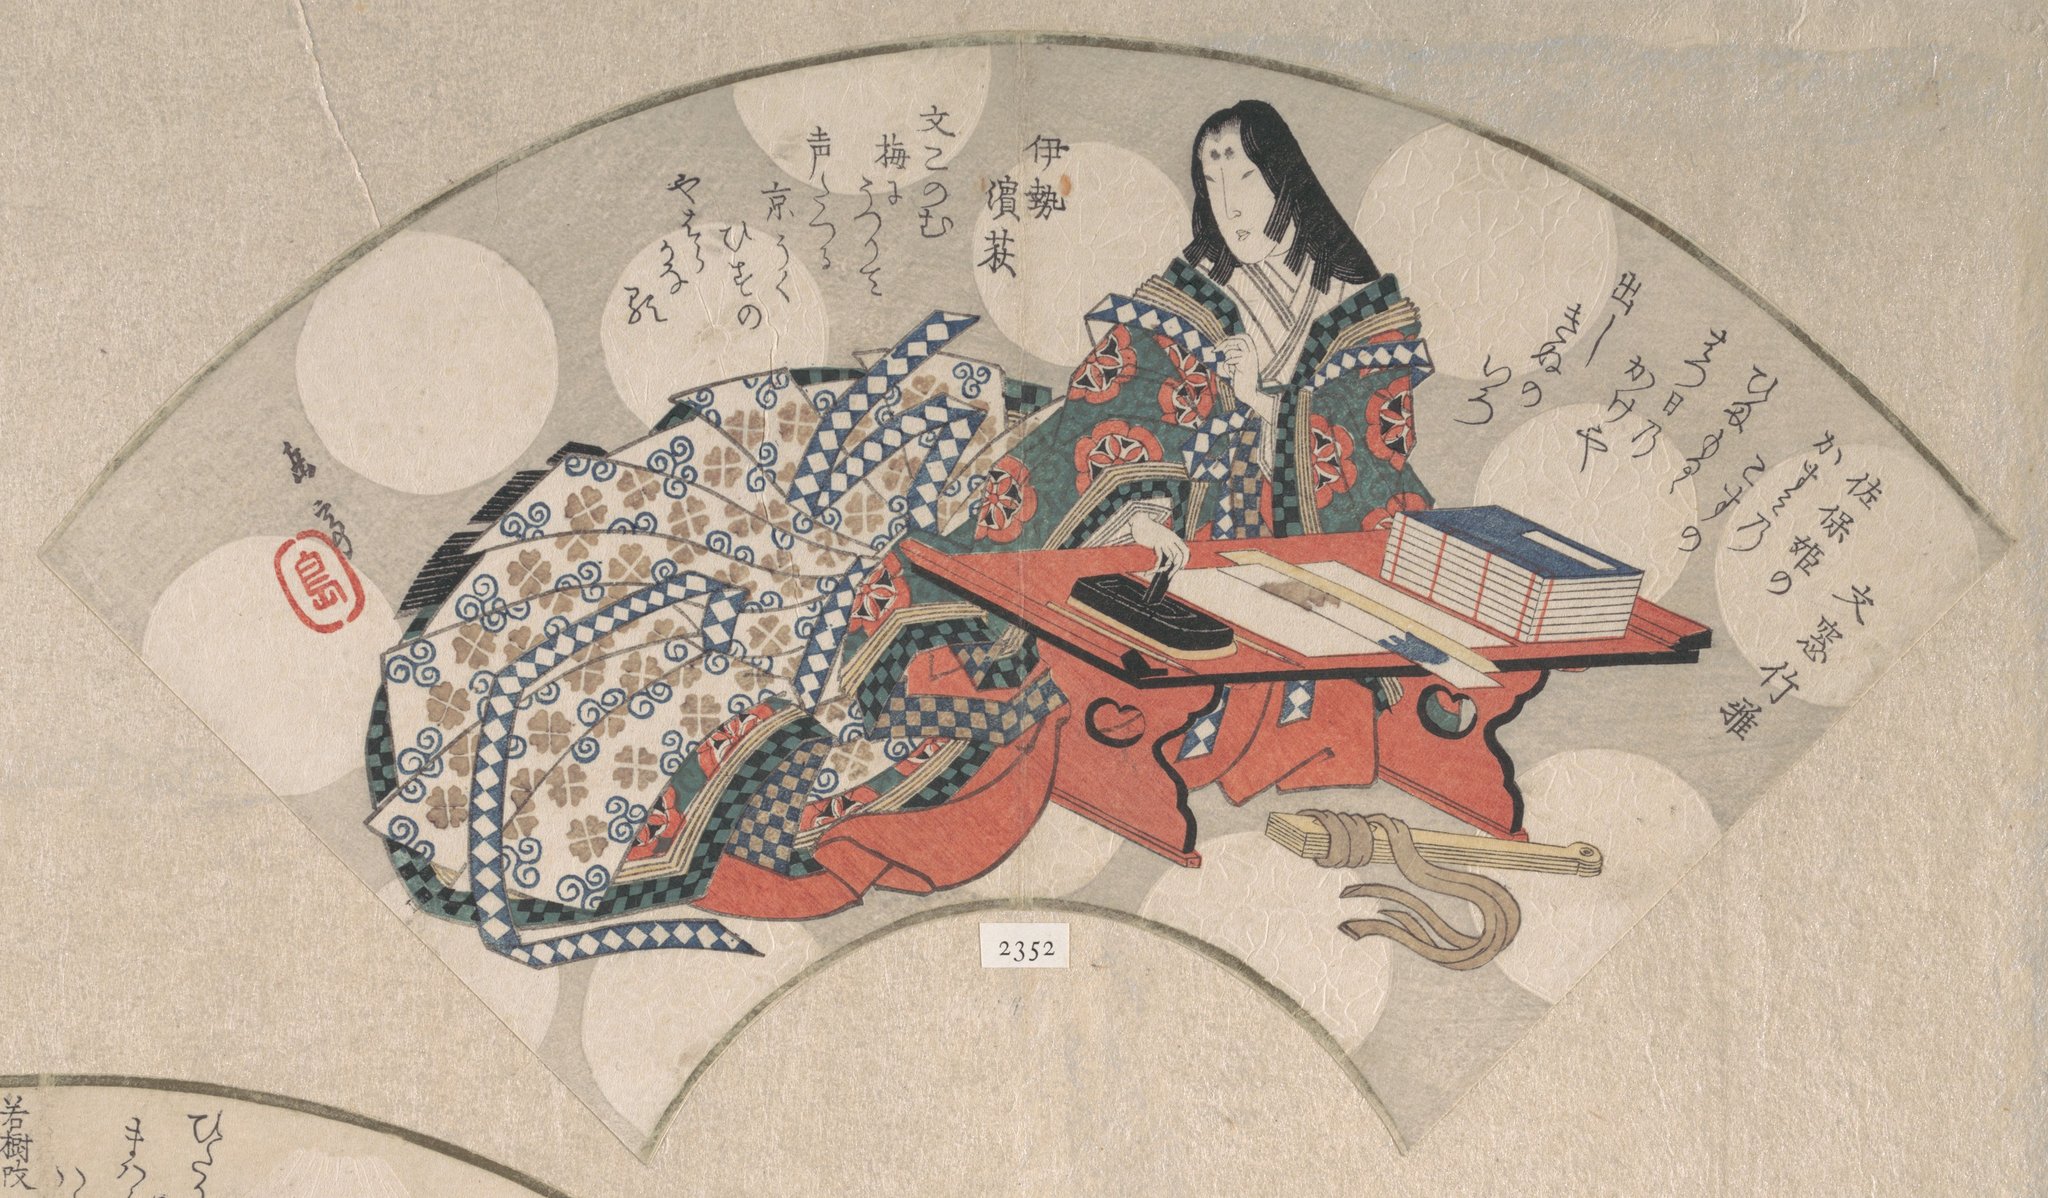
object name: print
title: Court Lady at Her Writing Table From the Spring Rain Collection (Harusame shū), vol. 3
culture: japanese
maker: yashima gakutei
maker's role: artist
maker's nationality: japanese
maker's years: 1786-1868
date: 1820-1829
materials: ink, paper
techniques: surimono, woodblock print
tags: women,writing,tables